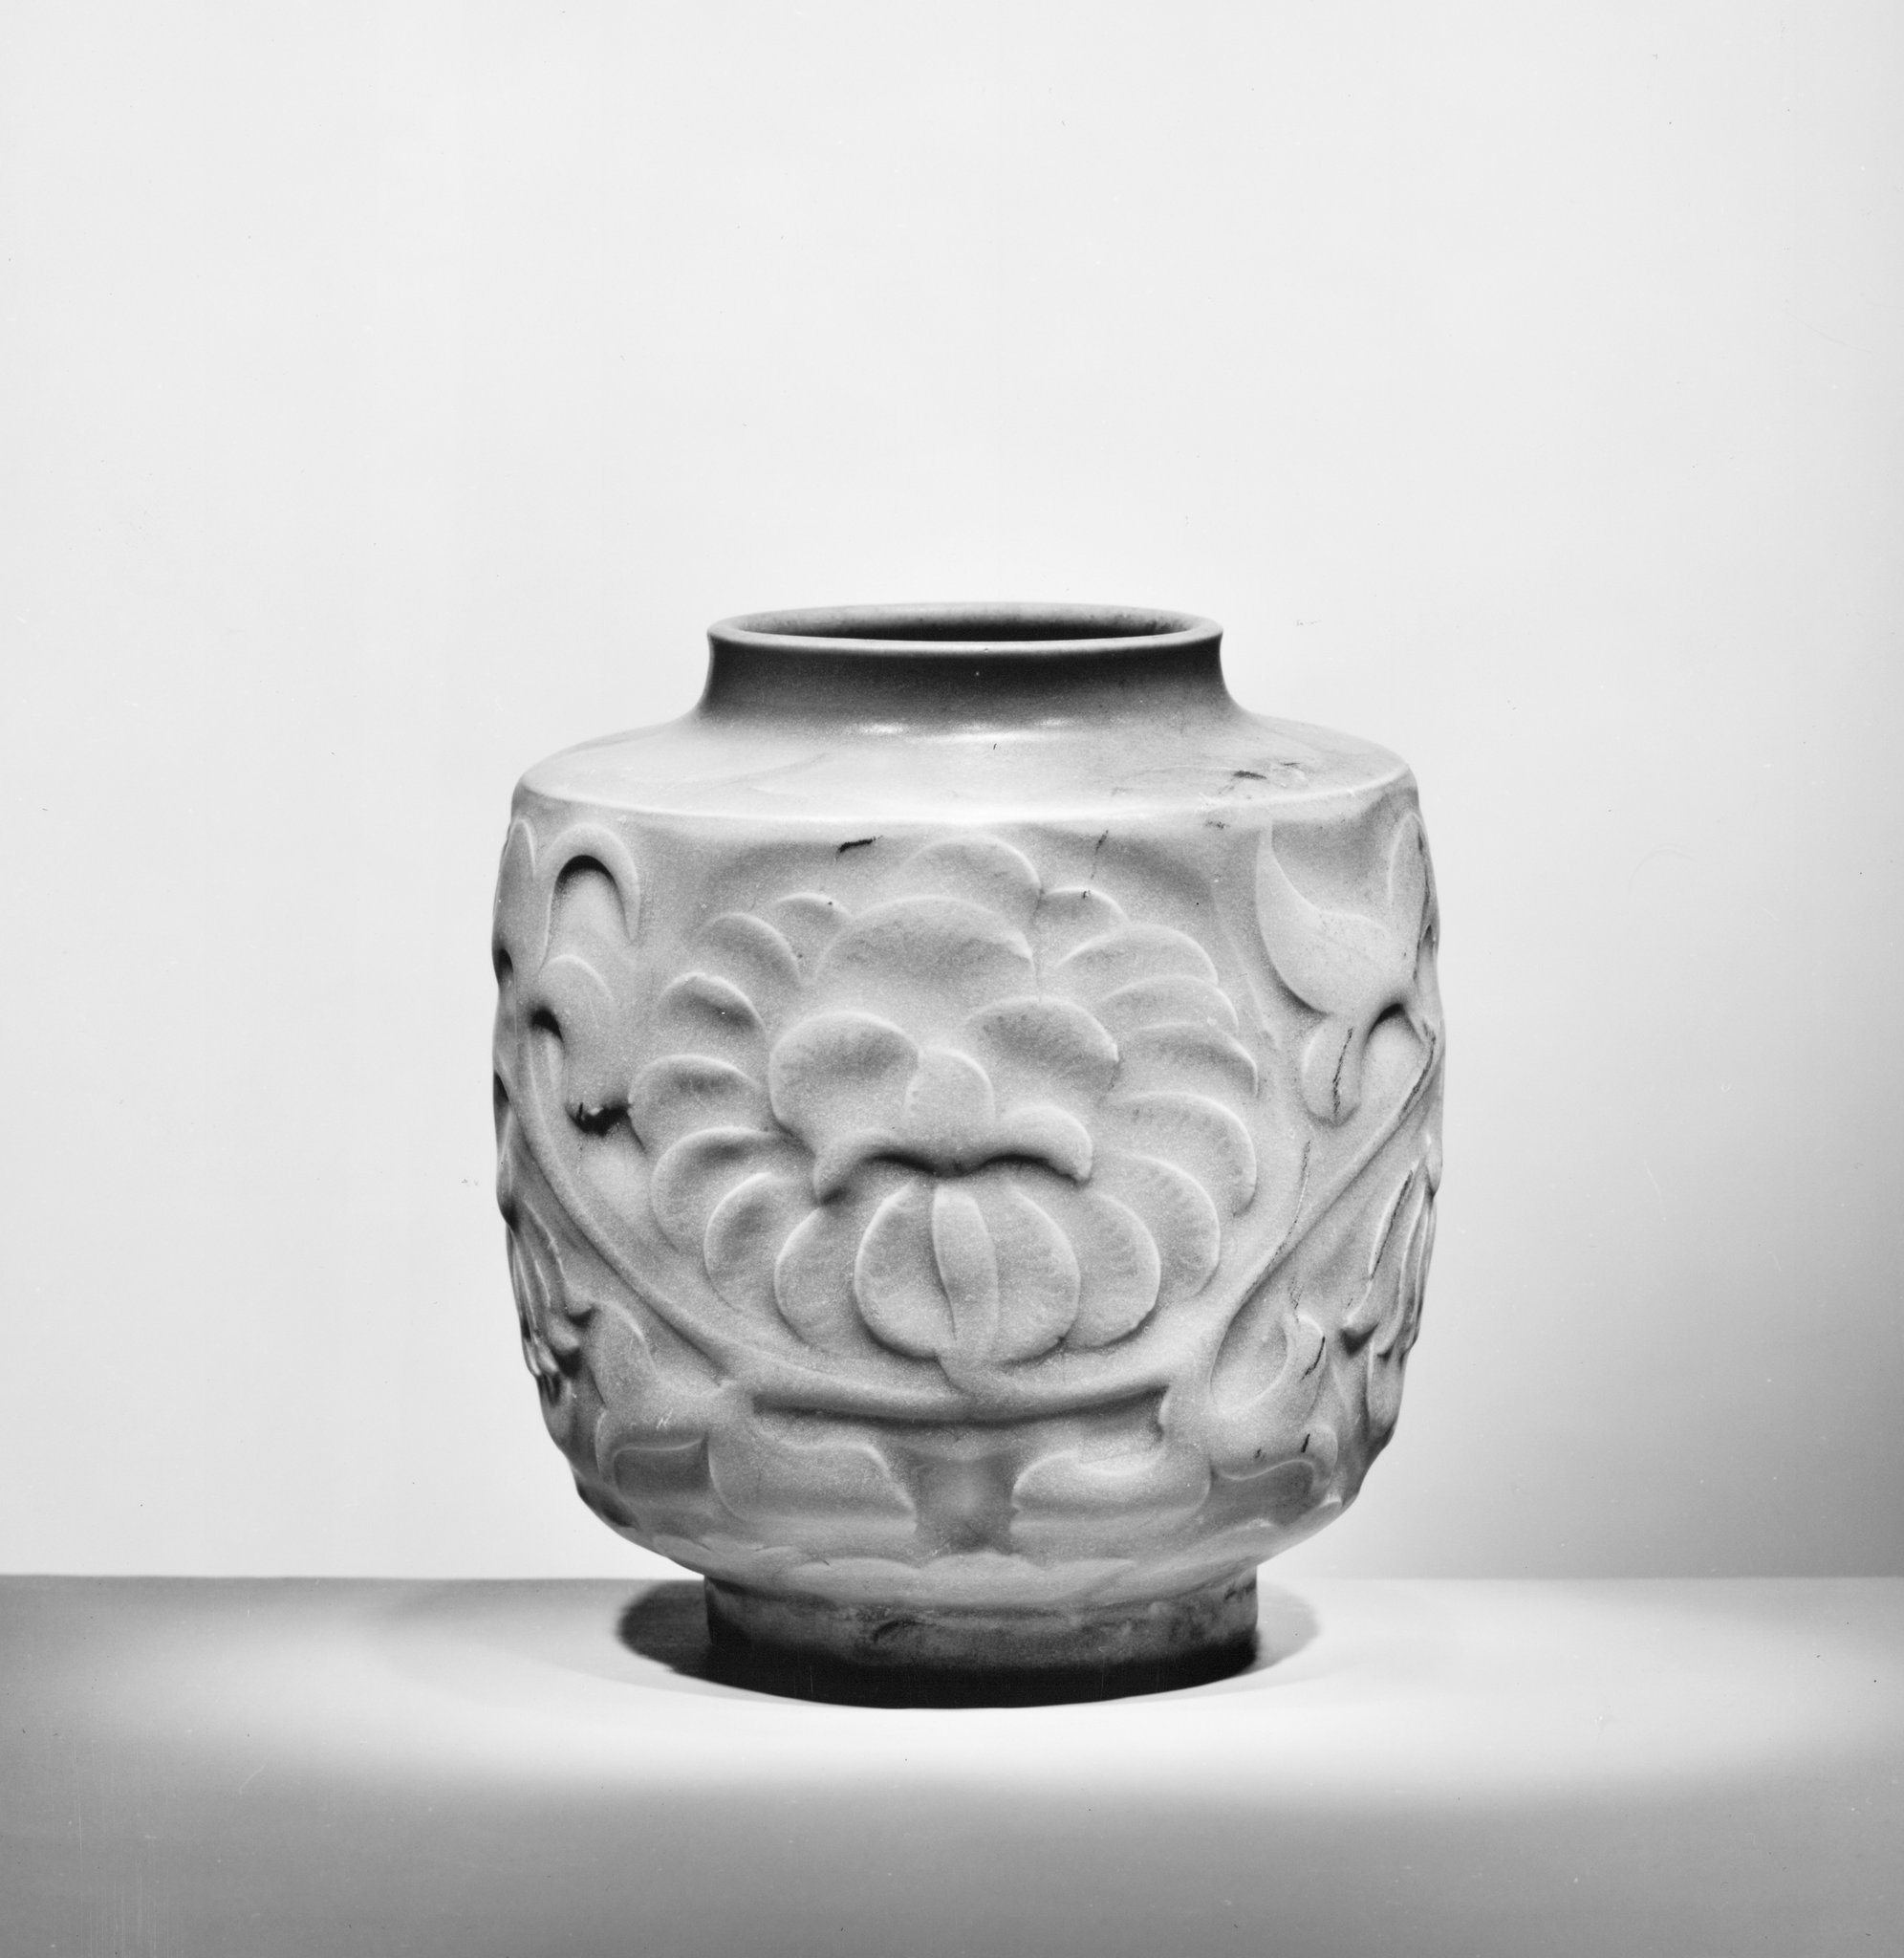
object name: jar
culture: chinese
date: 1001-1200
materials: ceramic glaze, glaze, stoneware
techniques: carving